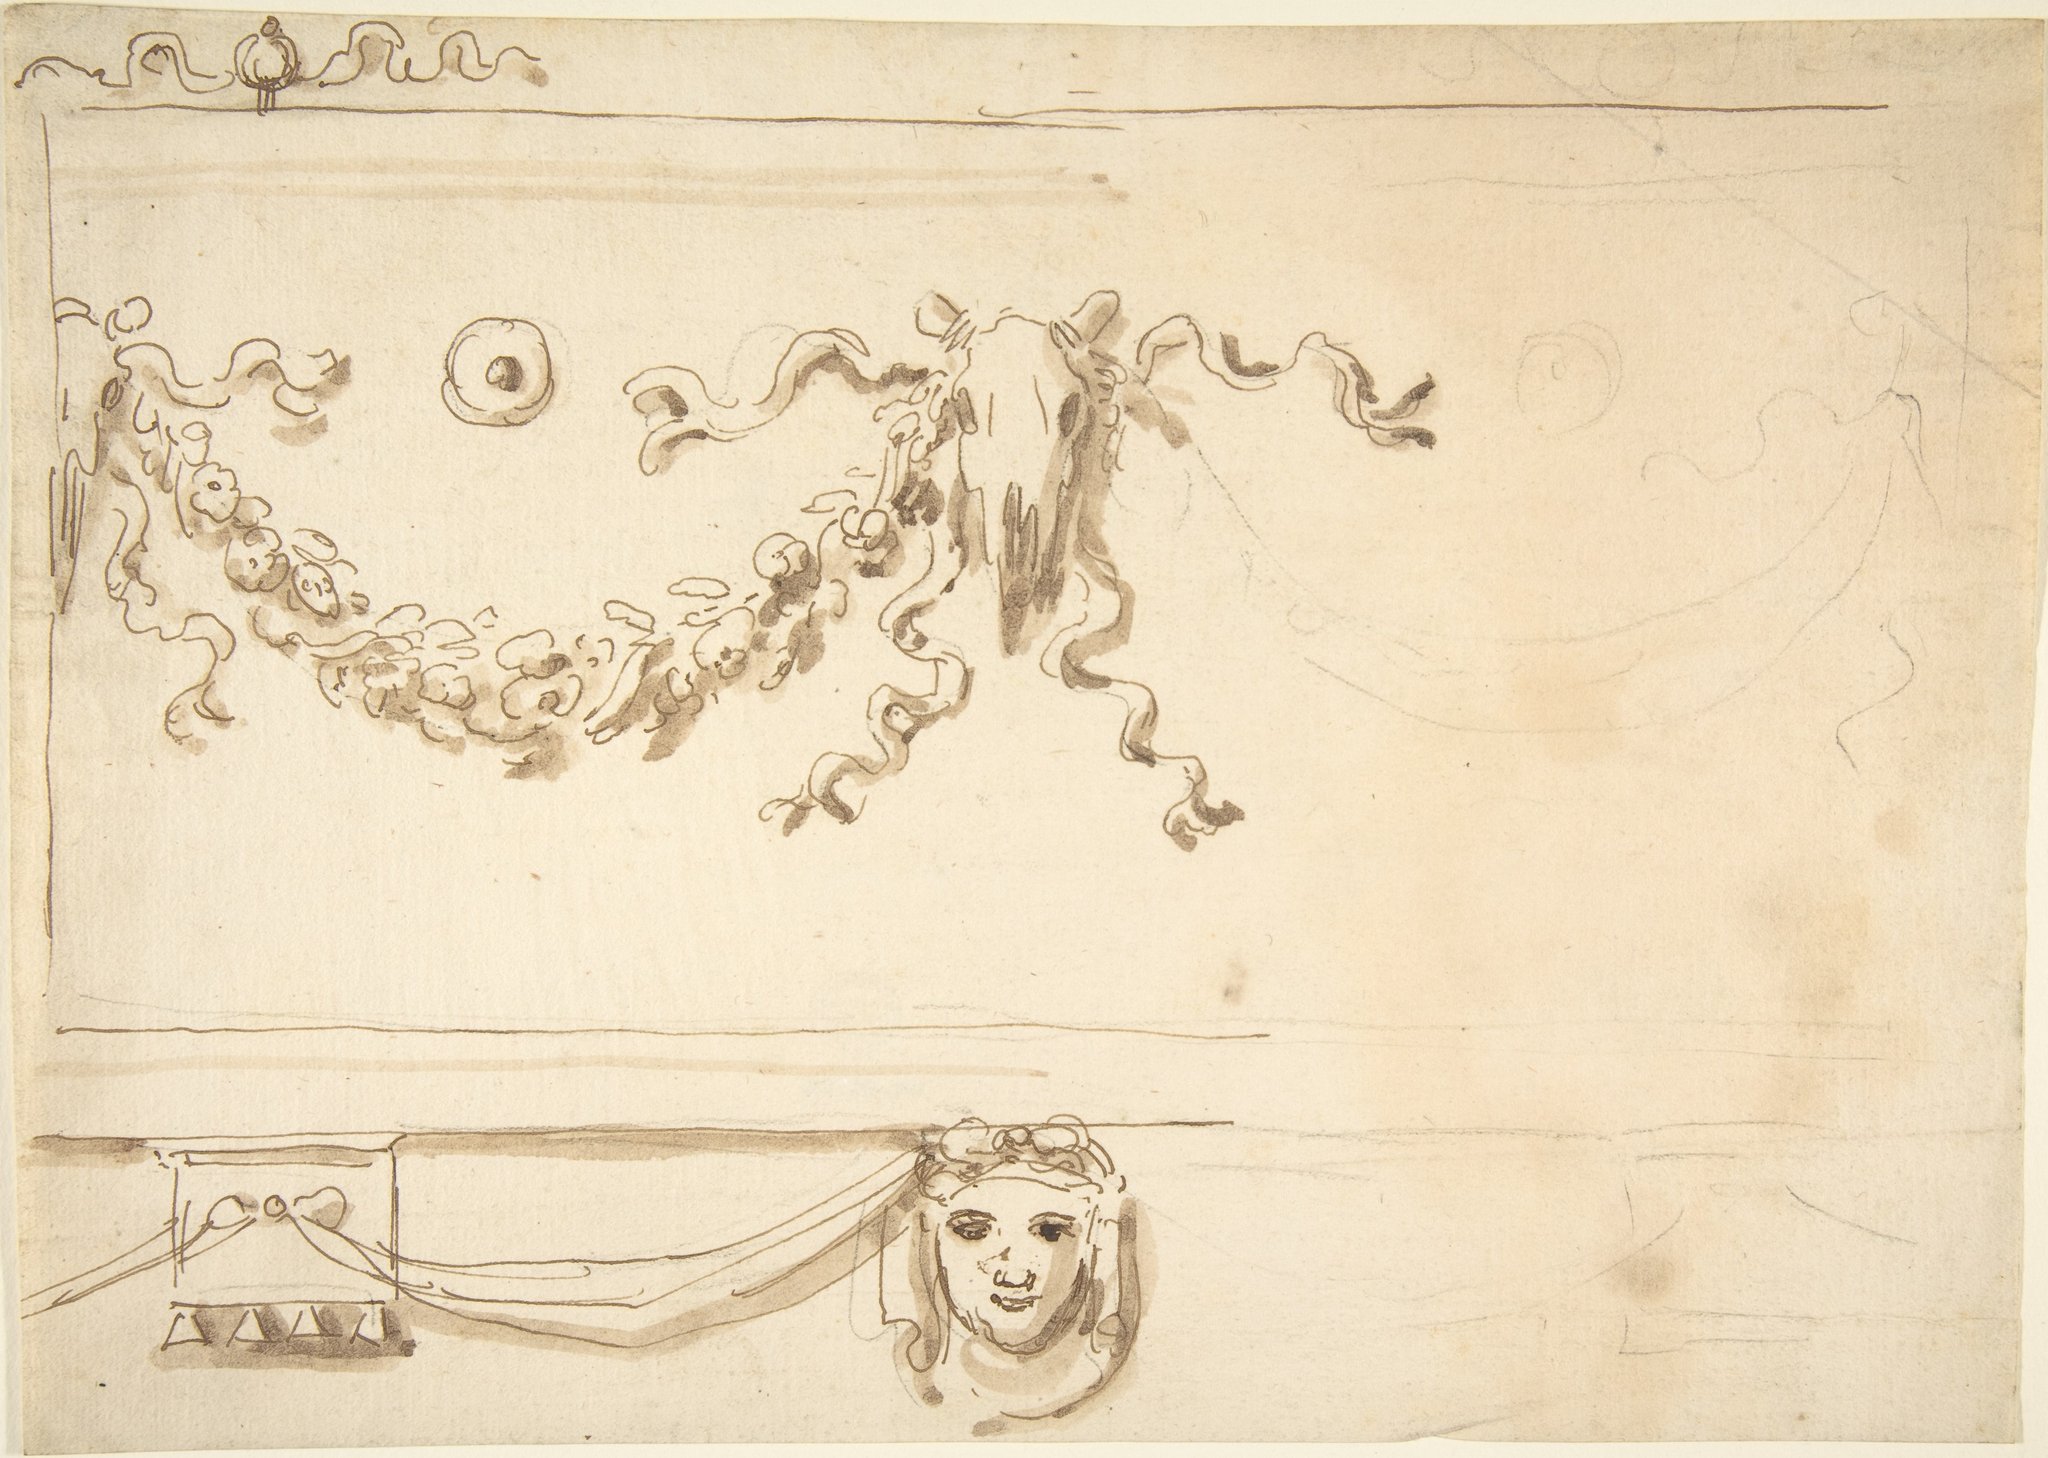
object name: ornament architecture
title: Design for a Frieze: Garland and Animal Skull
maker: anonymous, italian, 18th century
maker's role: artist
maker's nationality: italian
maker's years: 1700-1800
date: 1701-1800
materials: chalk, ink, paper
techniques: brush, pen, wash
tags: animals,garlands,skulls,faces